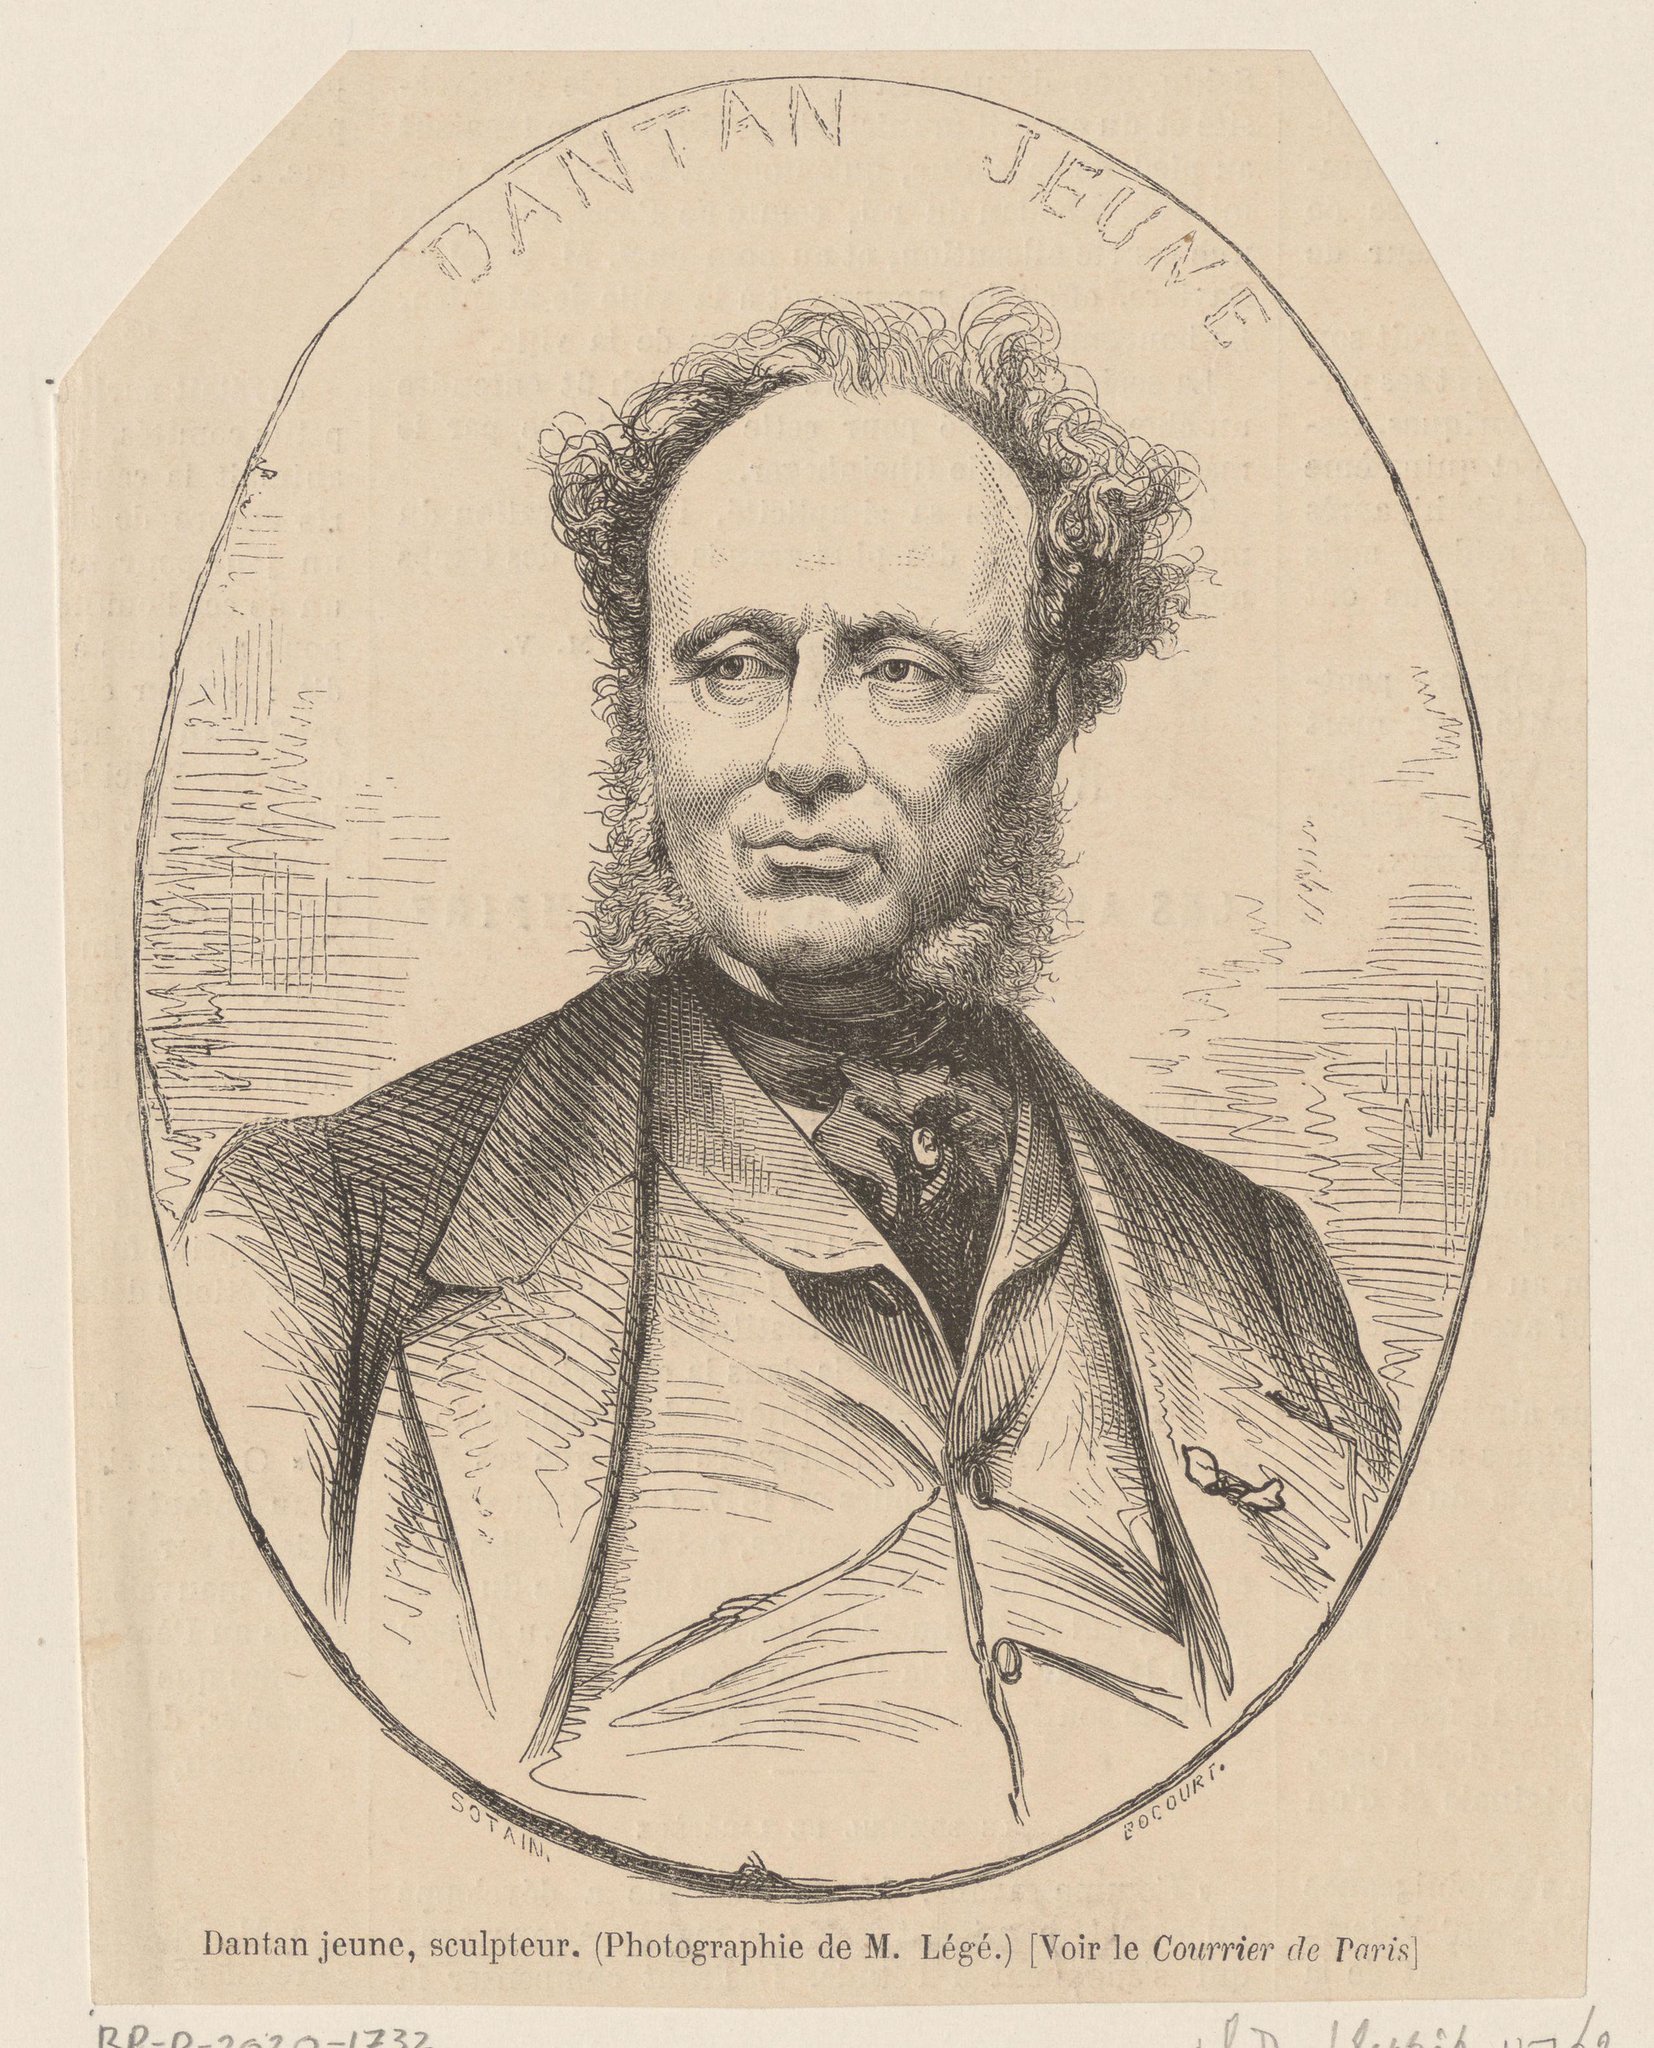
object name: photomechanical print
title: Portret van Jean-Pierre Dantan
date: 1869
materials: paper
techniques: letterpress printing, printing block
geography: paris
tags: paris, sculptor, jean-pierre dantan, portrait, self-portrait of sculptor, historical persons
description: Prent uit: Le Monde Illustré 13 (1869), nr. 649, 18 september 1869.